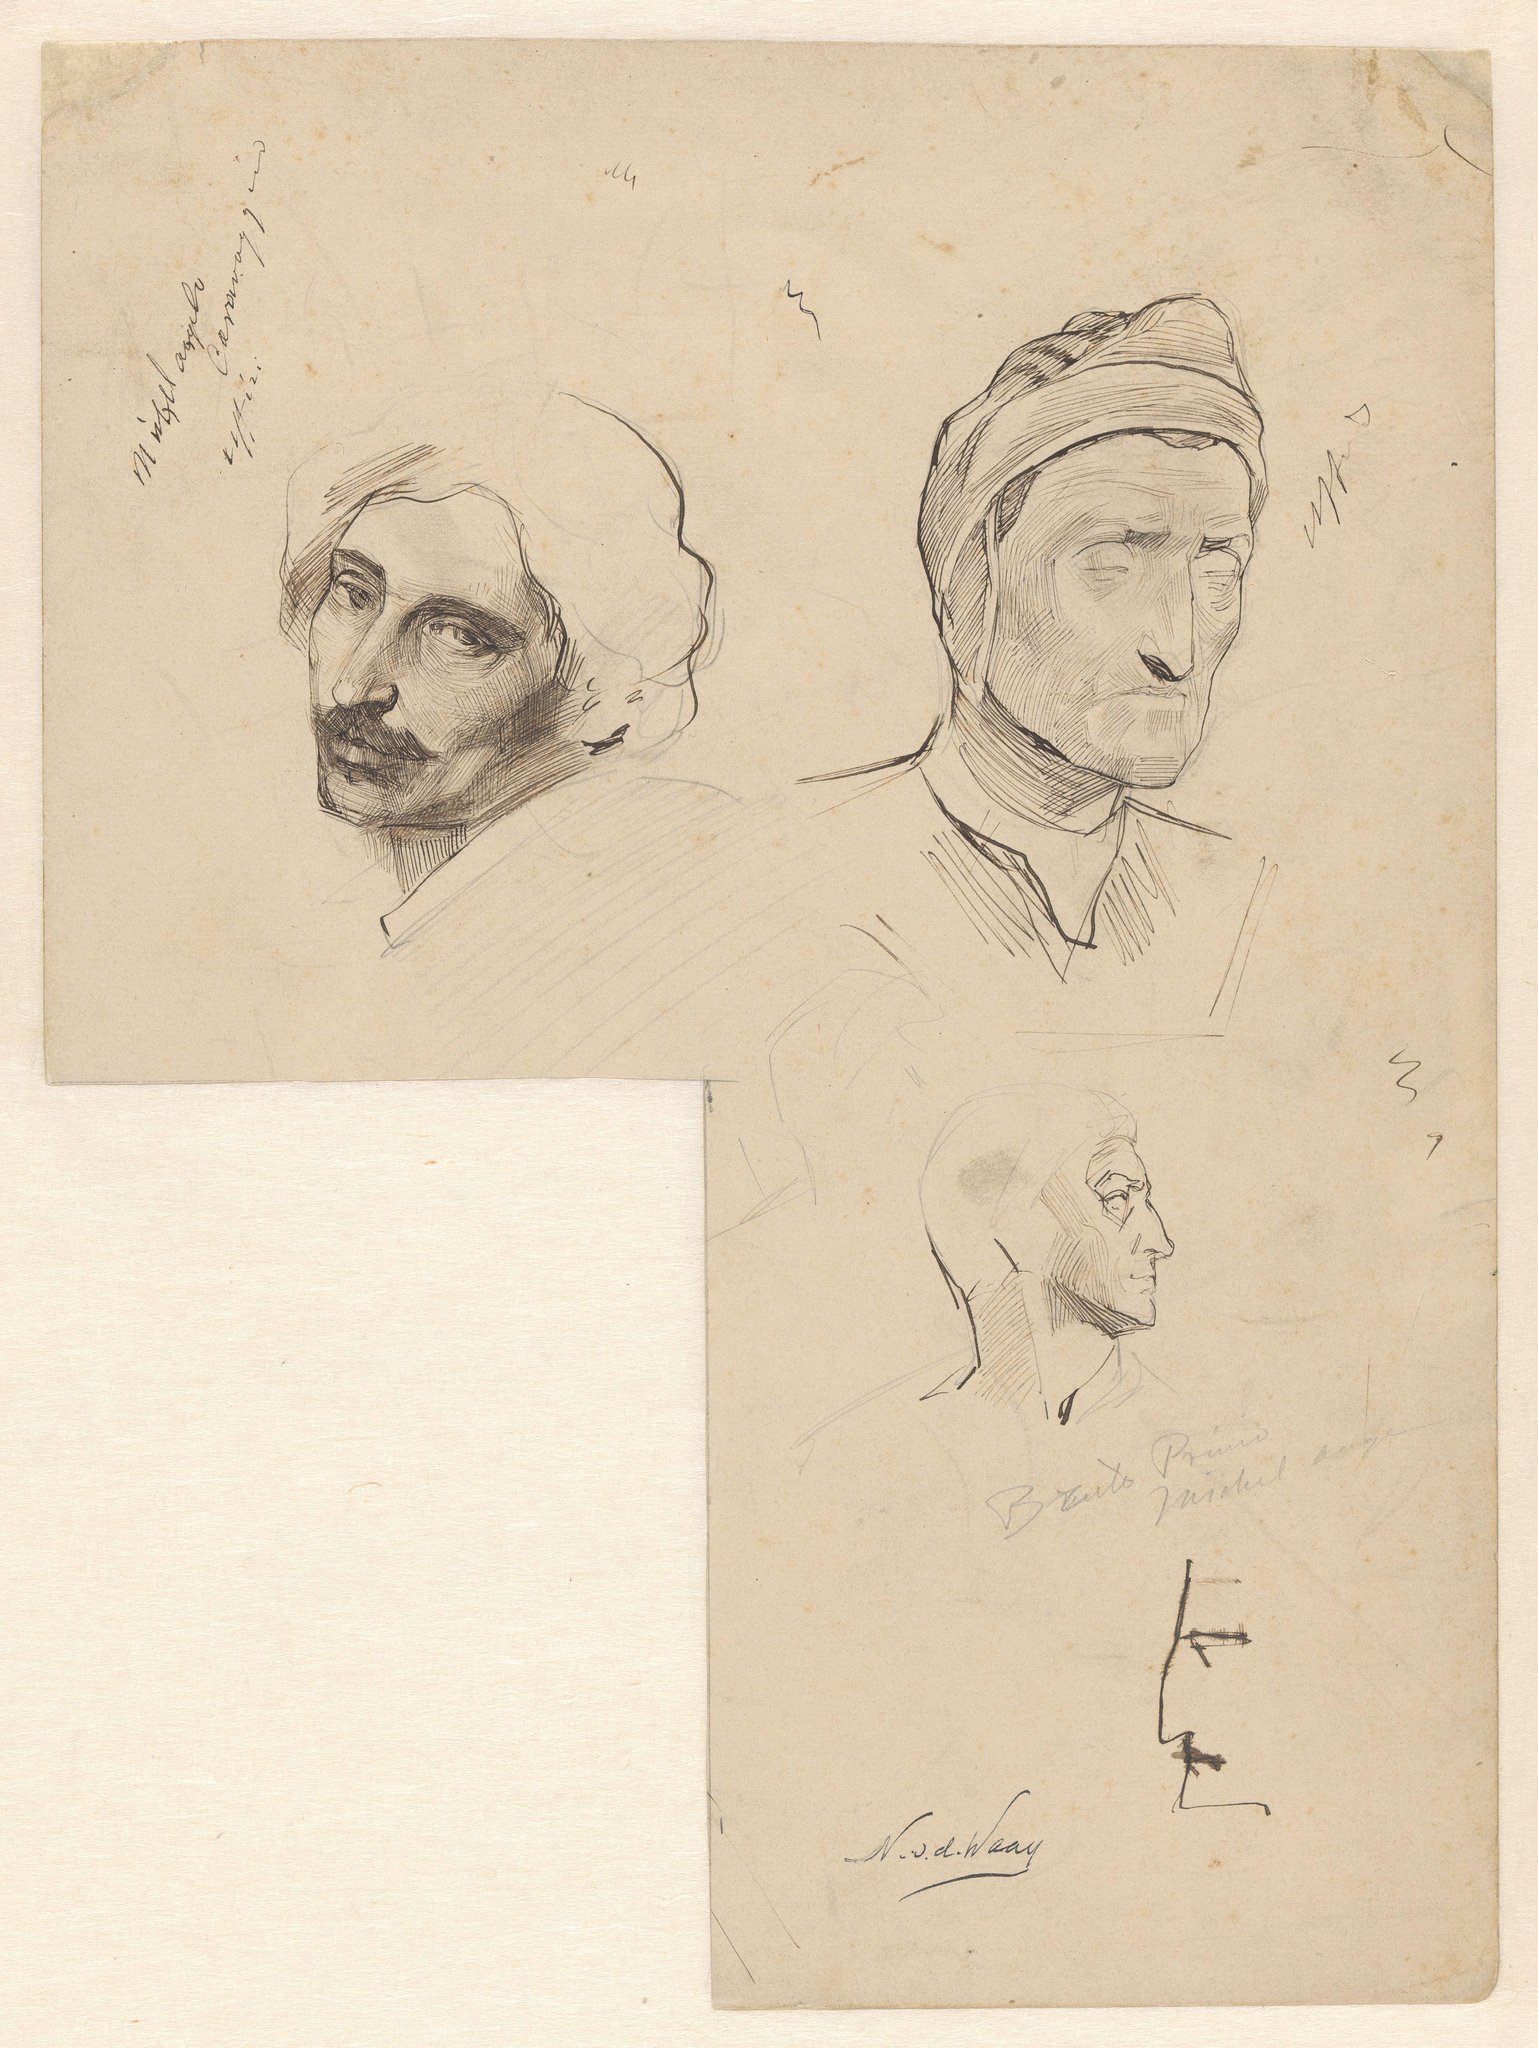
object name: drawing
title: Studieblad met een portret van Caravaggio en bustes van Dante en Brutus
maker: nicolaas van der waay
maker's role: draughtsman, painter, print maker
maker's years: 1855-1936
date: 1884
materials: ink, paper, pencil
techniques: pen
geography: florence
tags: painter, caravaggio, dante alighieri, historical persons, portrait, self-portrait of artist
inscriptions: collector's mark: Lugt 2228, collector's mark: Lugt 2760, annotation: ‘[...]J 136/30’, inscription: ‘Michelangelo Caravaggio/ Uffizi/ Uffizi/ Brutus Primo/ Michel ange’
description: De buste van Brutus is getekend naar het beeld van Michelangelo.